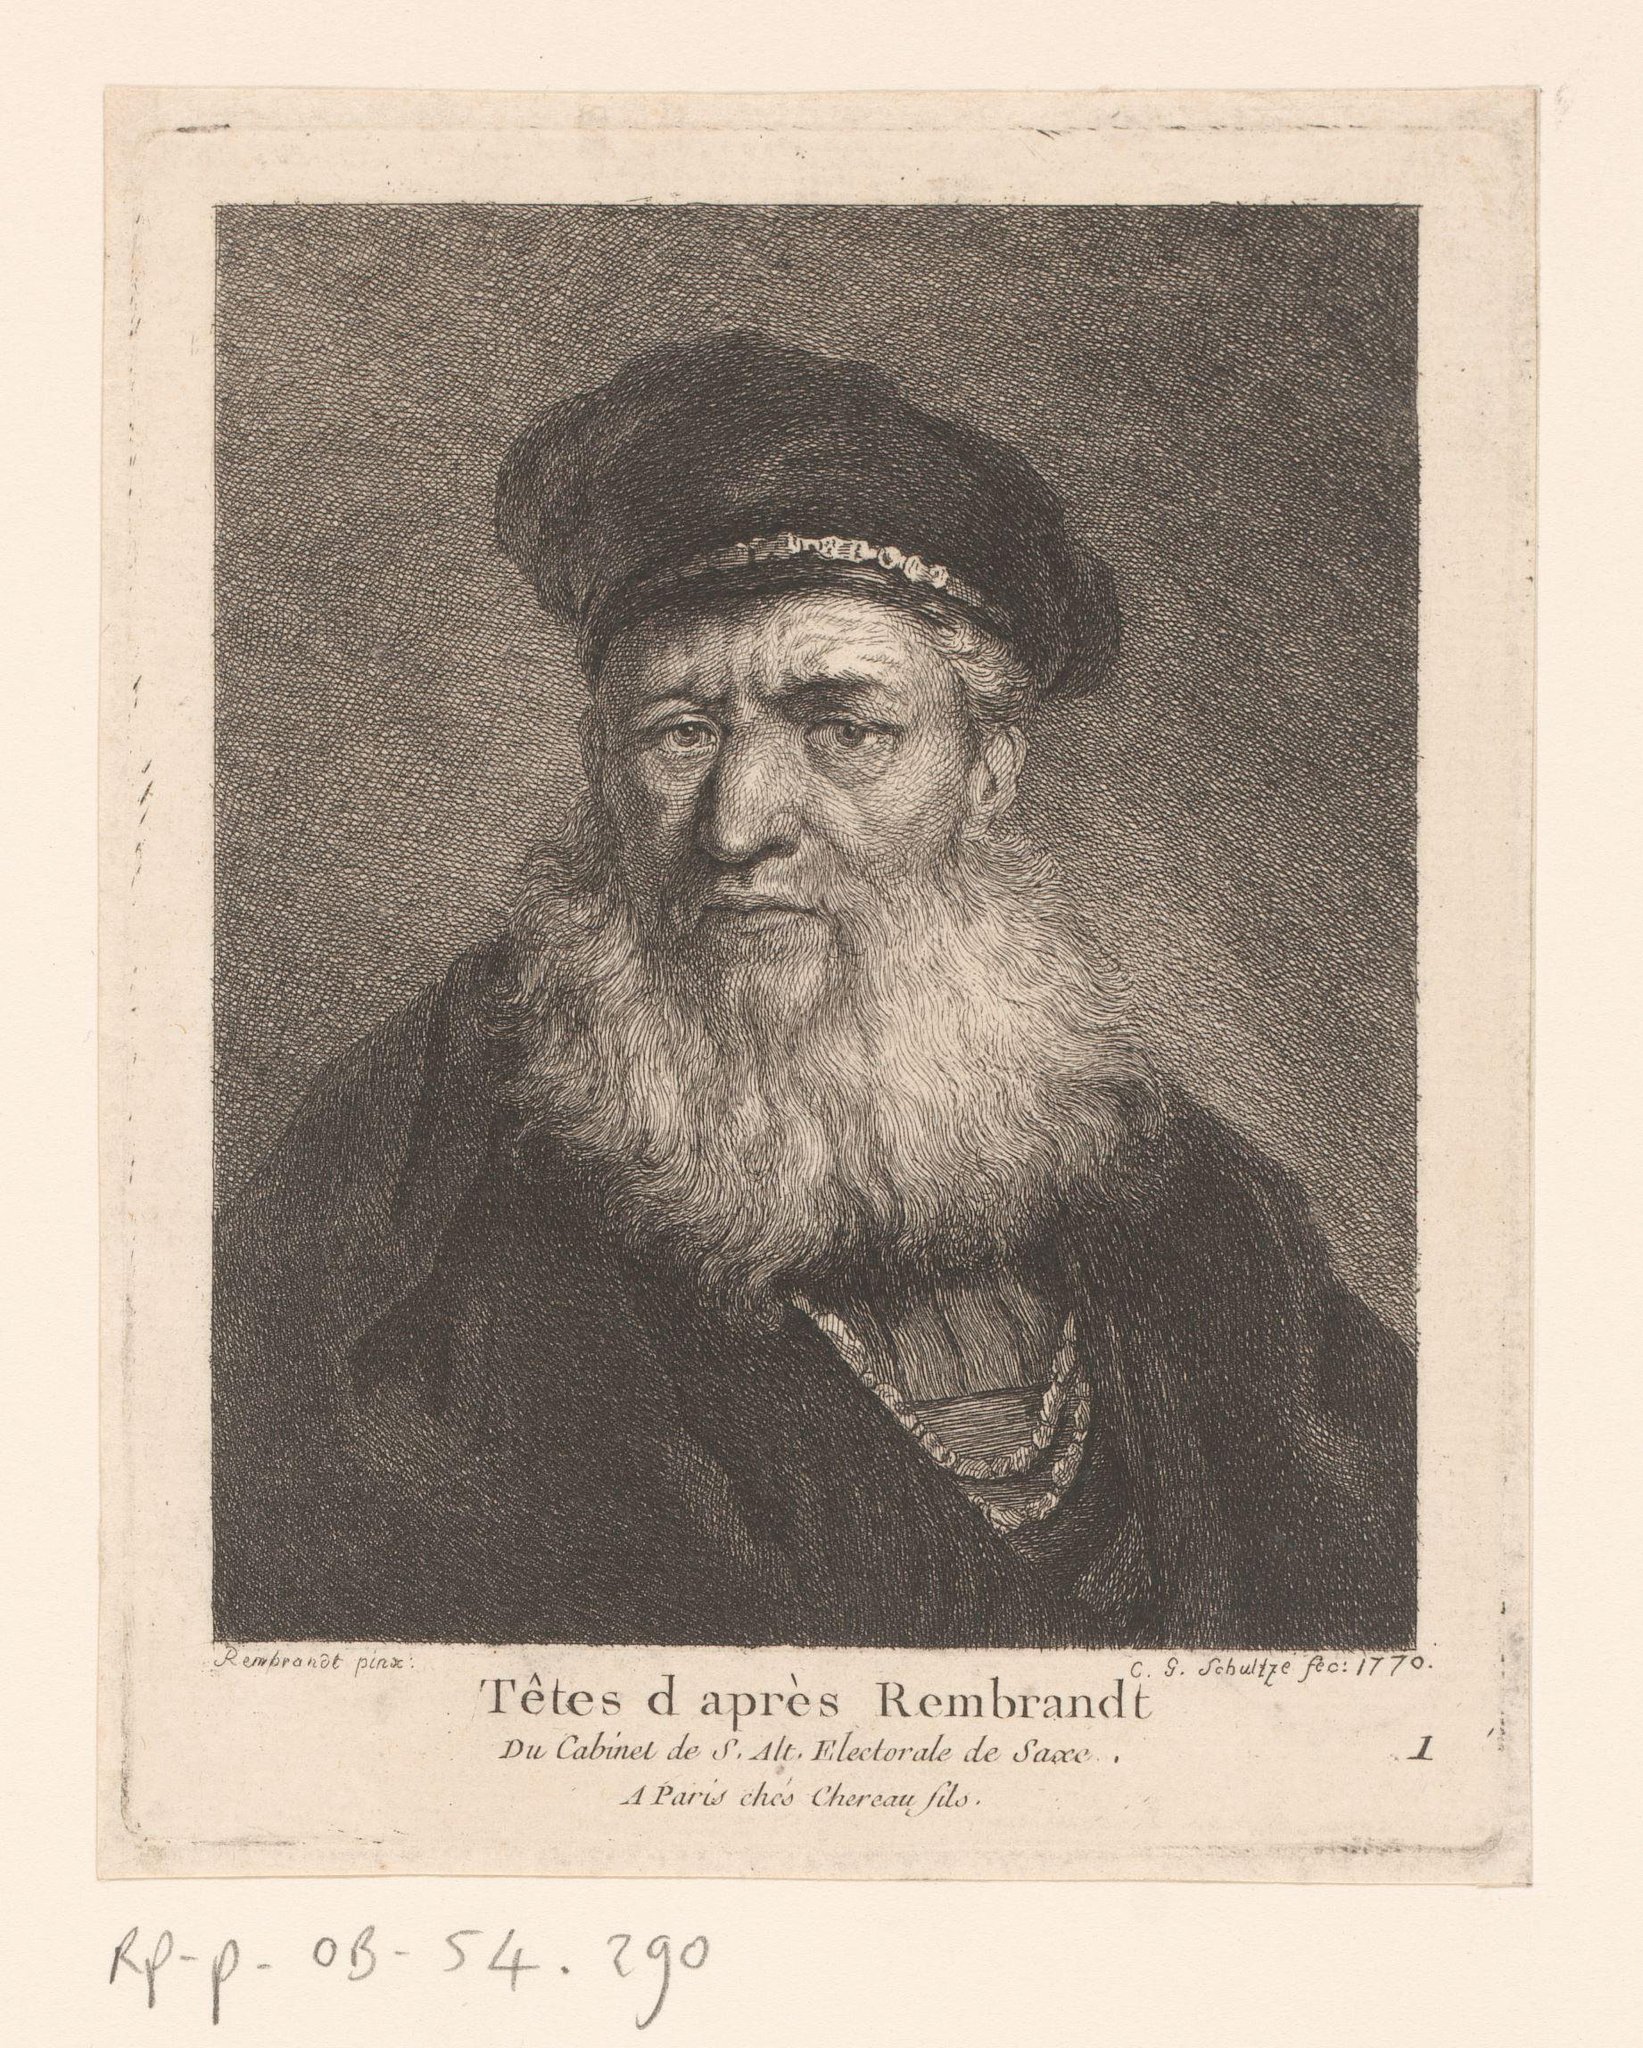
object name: print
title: Oude man met baret en baard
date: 1770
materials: paper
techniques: etching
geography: paris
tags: old man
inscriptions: collector's mark: Lugt 240